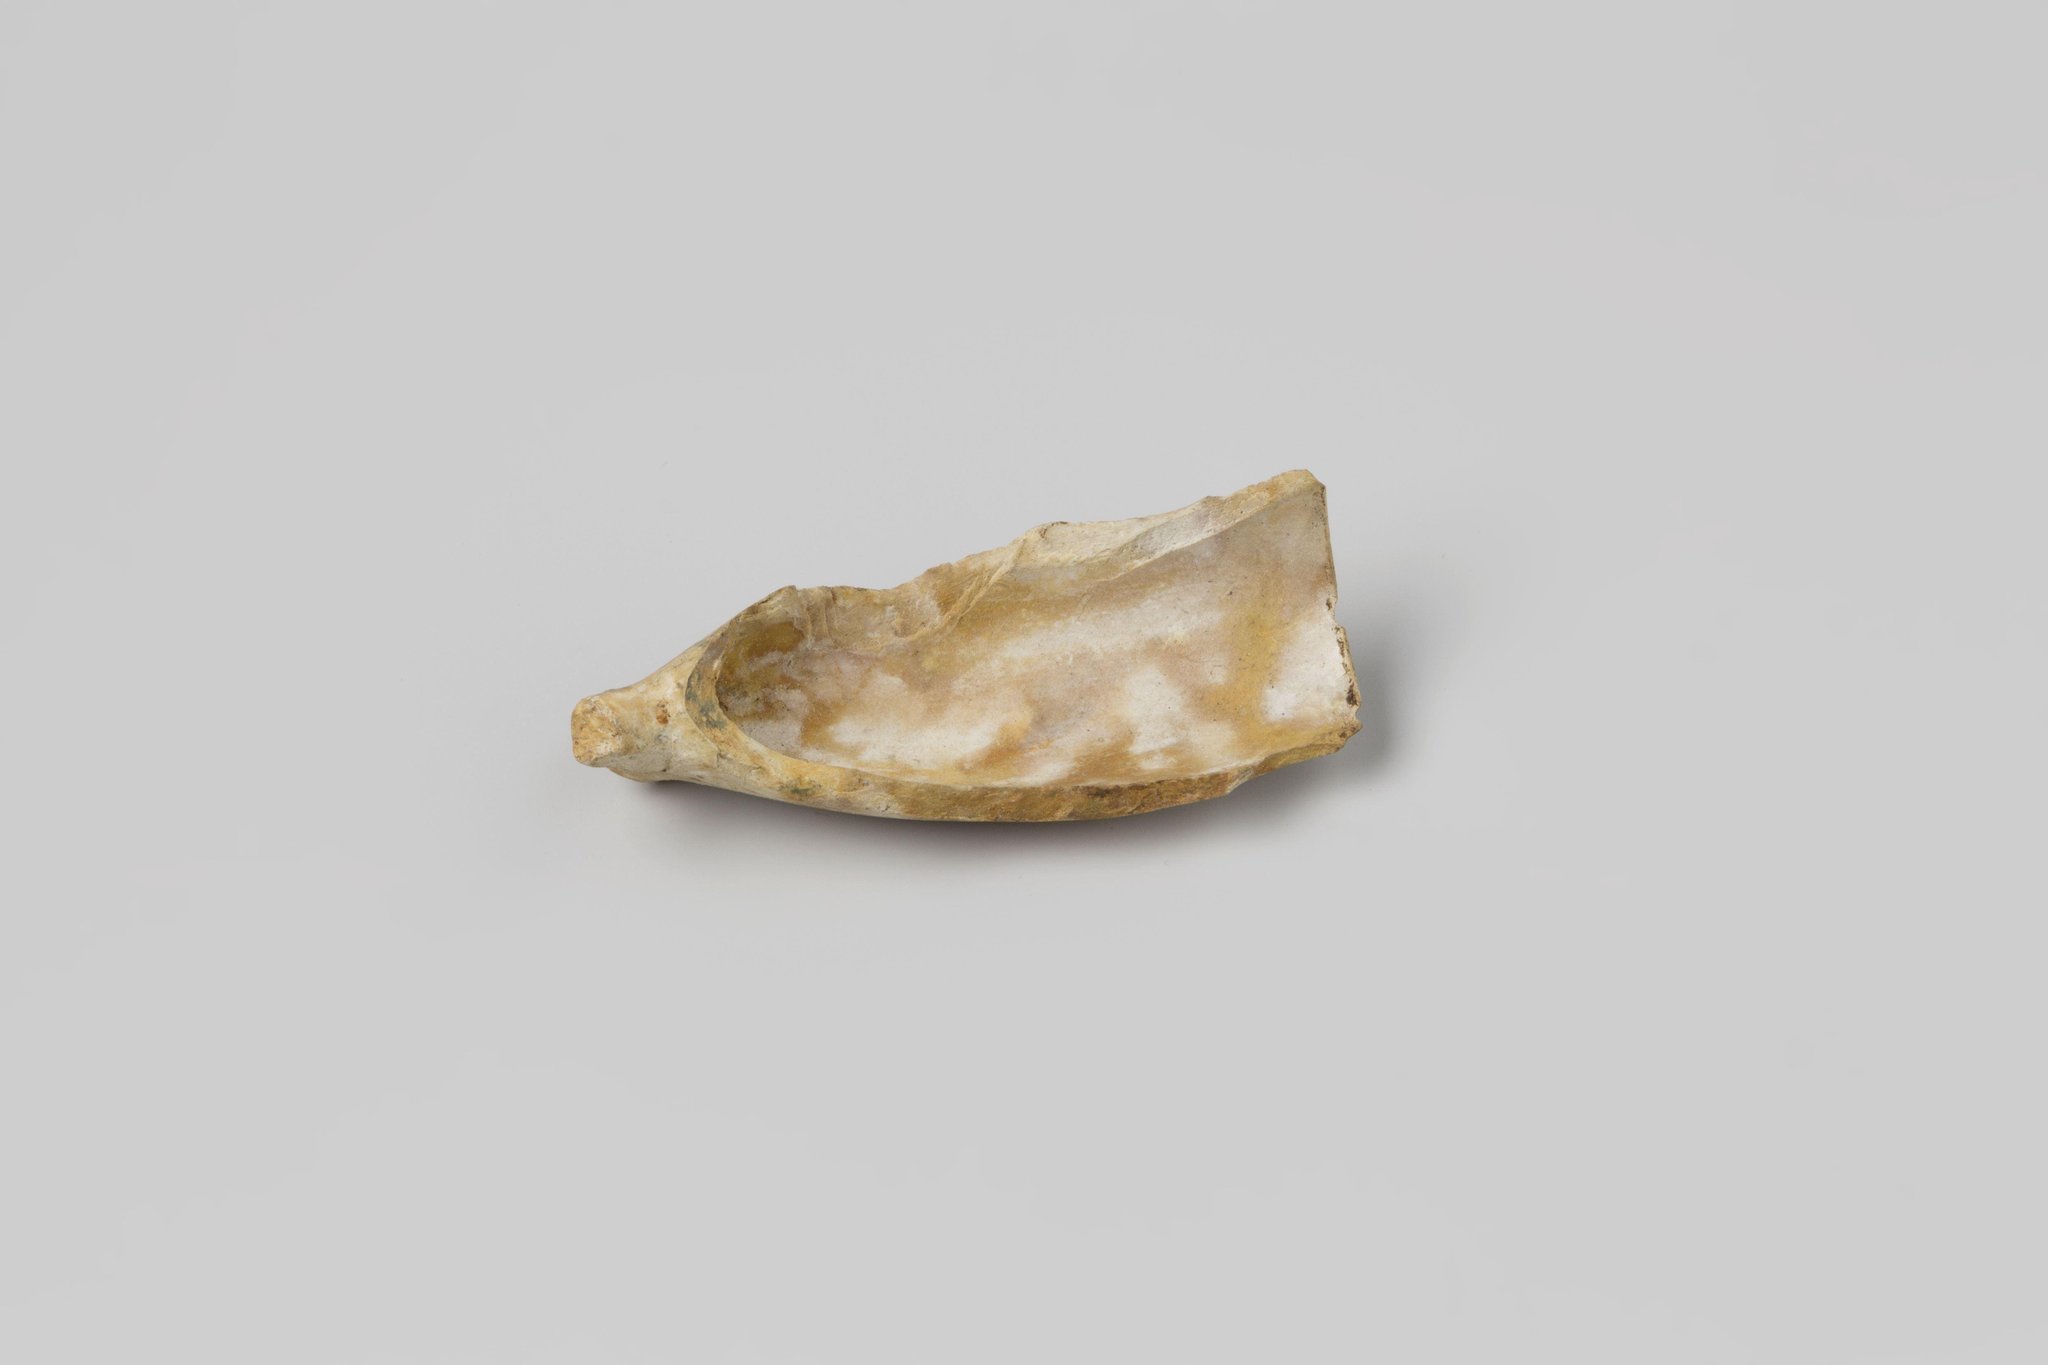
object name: pipe bowl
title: Fragment pijpenkop uit het wrak van de Oost-Indiëvaarder Hollandia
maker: Anonymous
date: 1700-1743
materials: clay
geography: netherlands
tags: verenigde oostindische compagnie, hollandia (schip), annet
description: Pipe, bowl, heelmark: coat of arms of the province of Gelderland; fragm, 1hsm6.